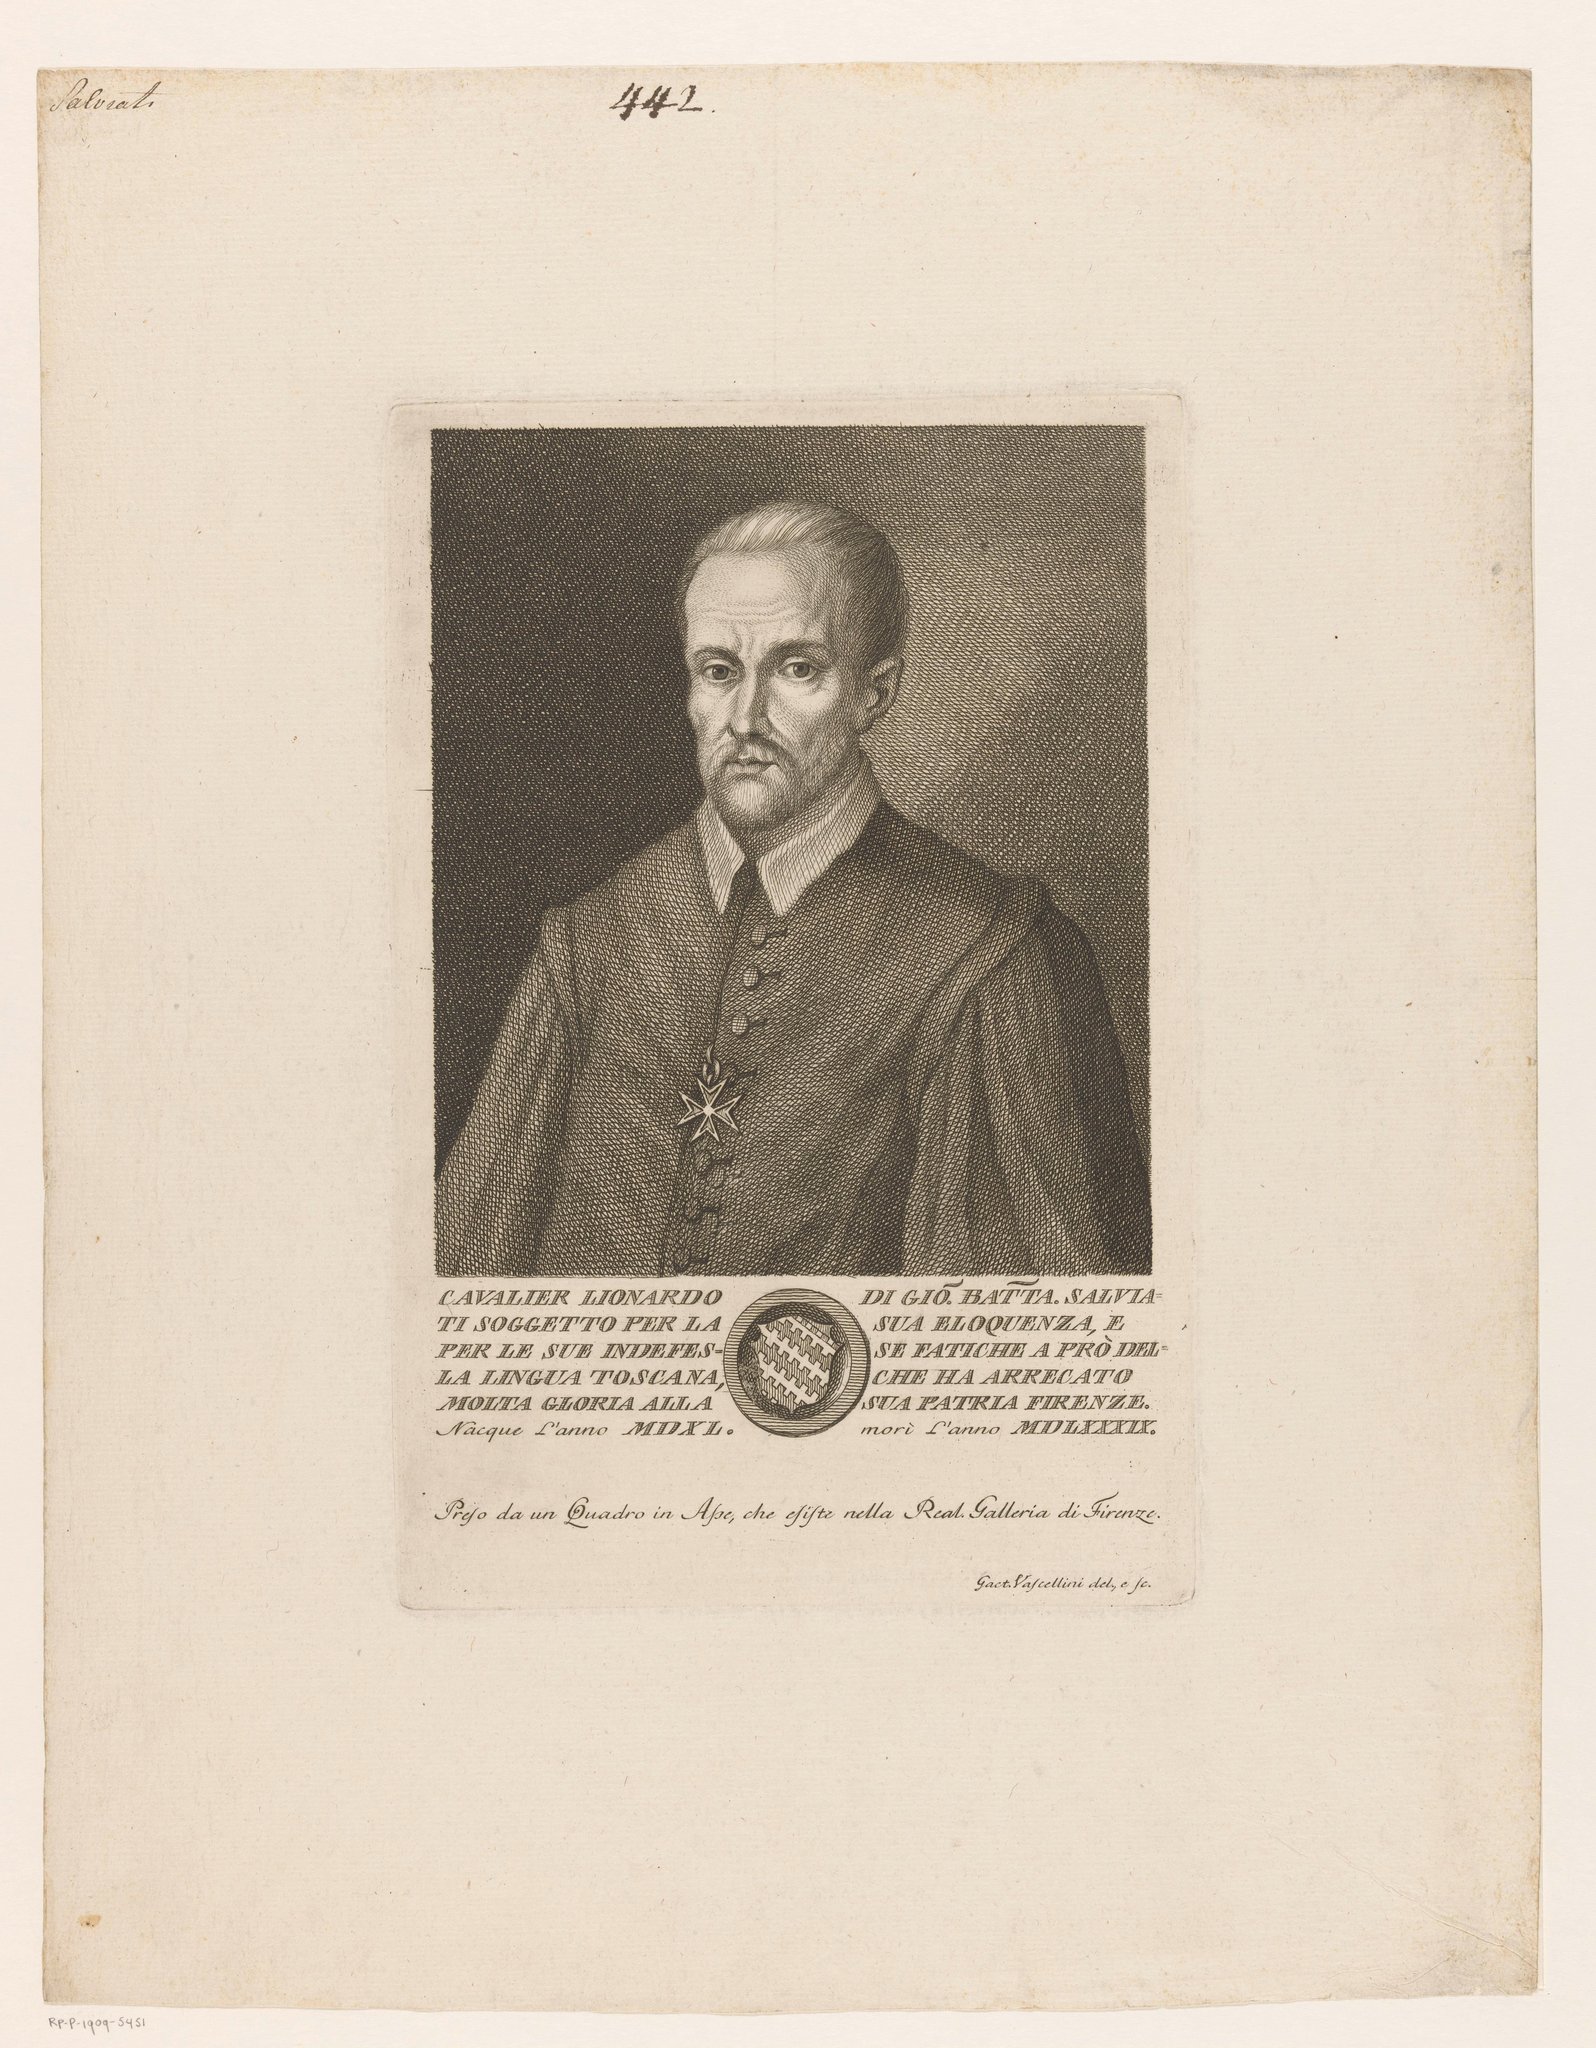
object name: print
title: Portret van humanist Leonardo Salviati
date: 1755-1805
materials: paper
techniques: engraving, etching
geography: italy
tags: historical persons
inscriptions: collector's mark: Lugt 2228, inscription: ‘Salviati 442’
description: Onder het portret een tekst in het Italiaans en een wapenschild in een cirkelvormig kader.